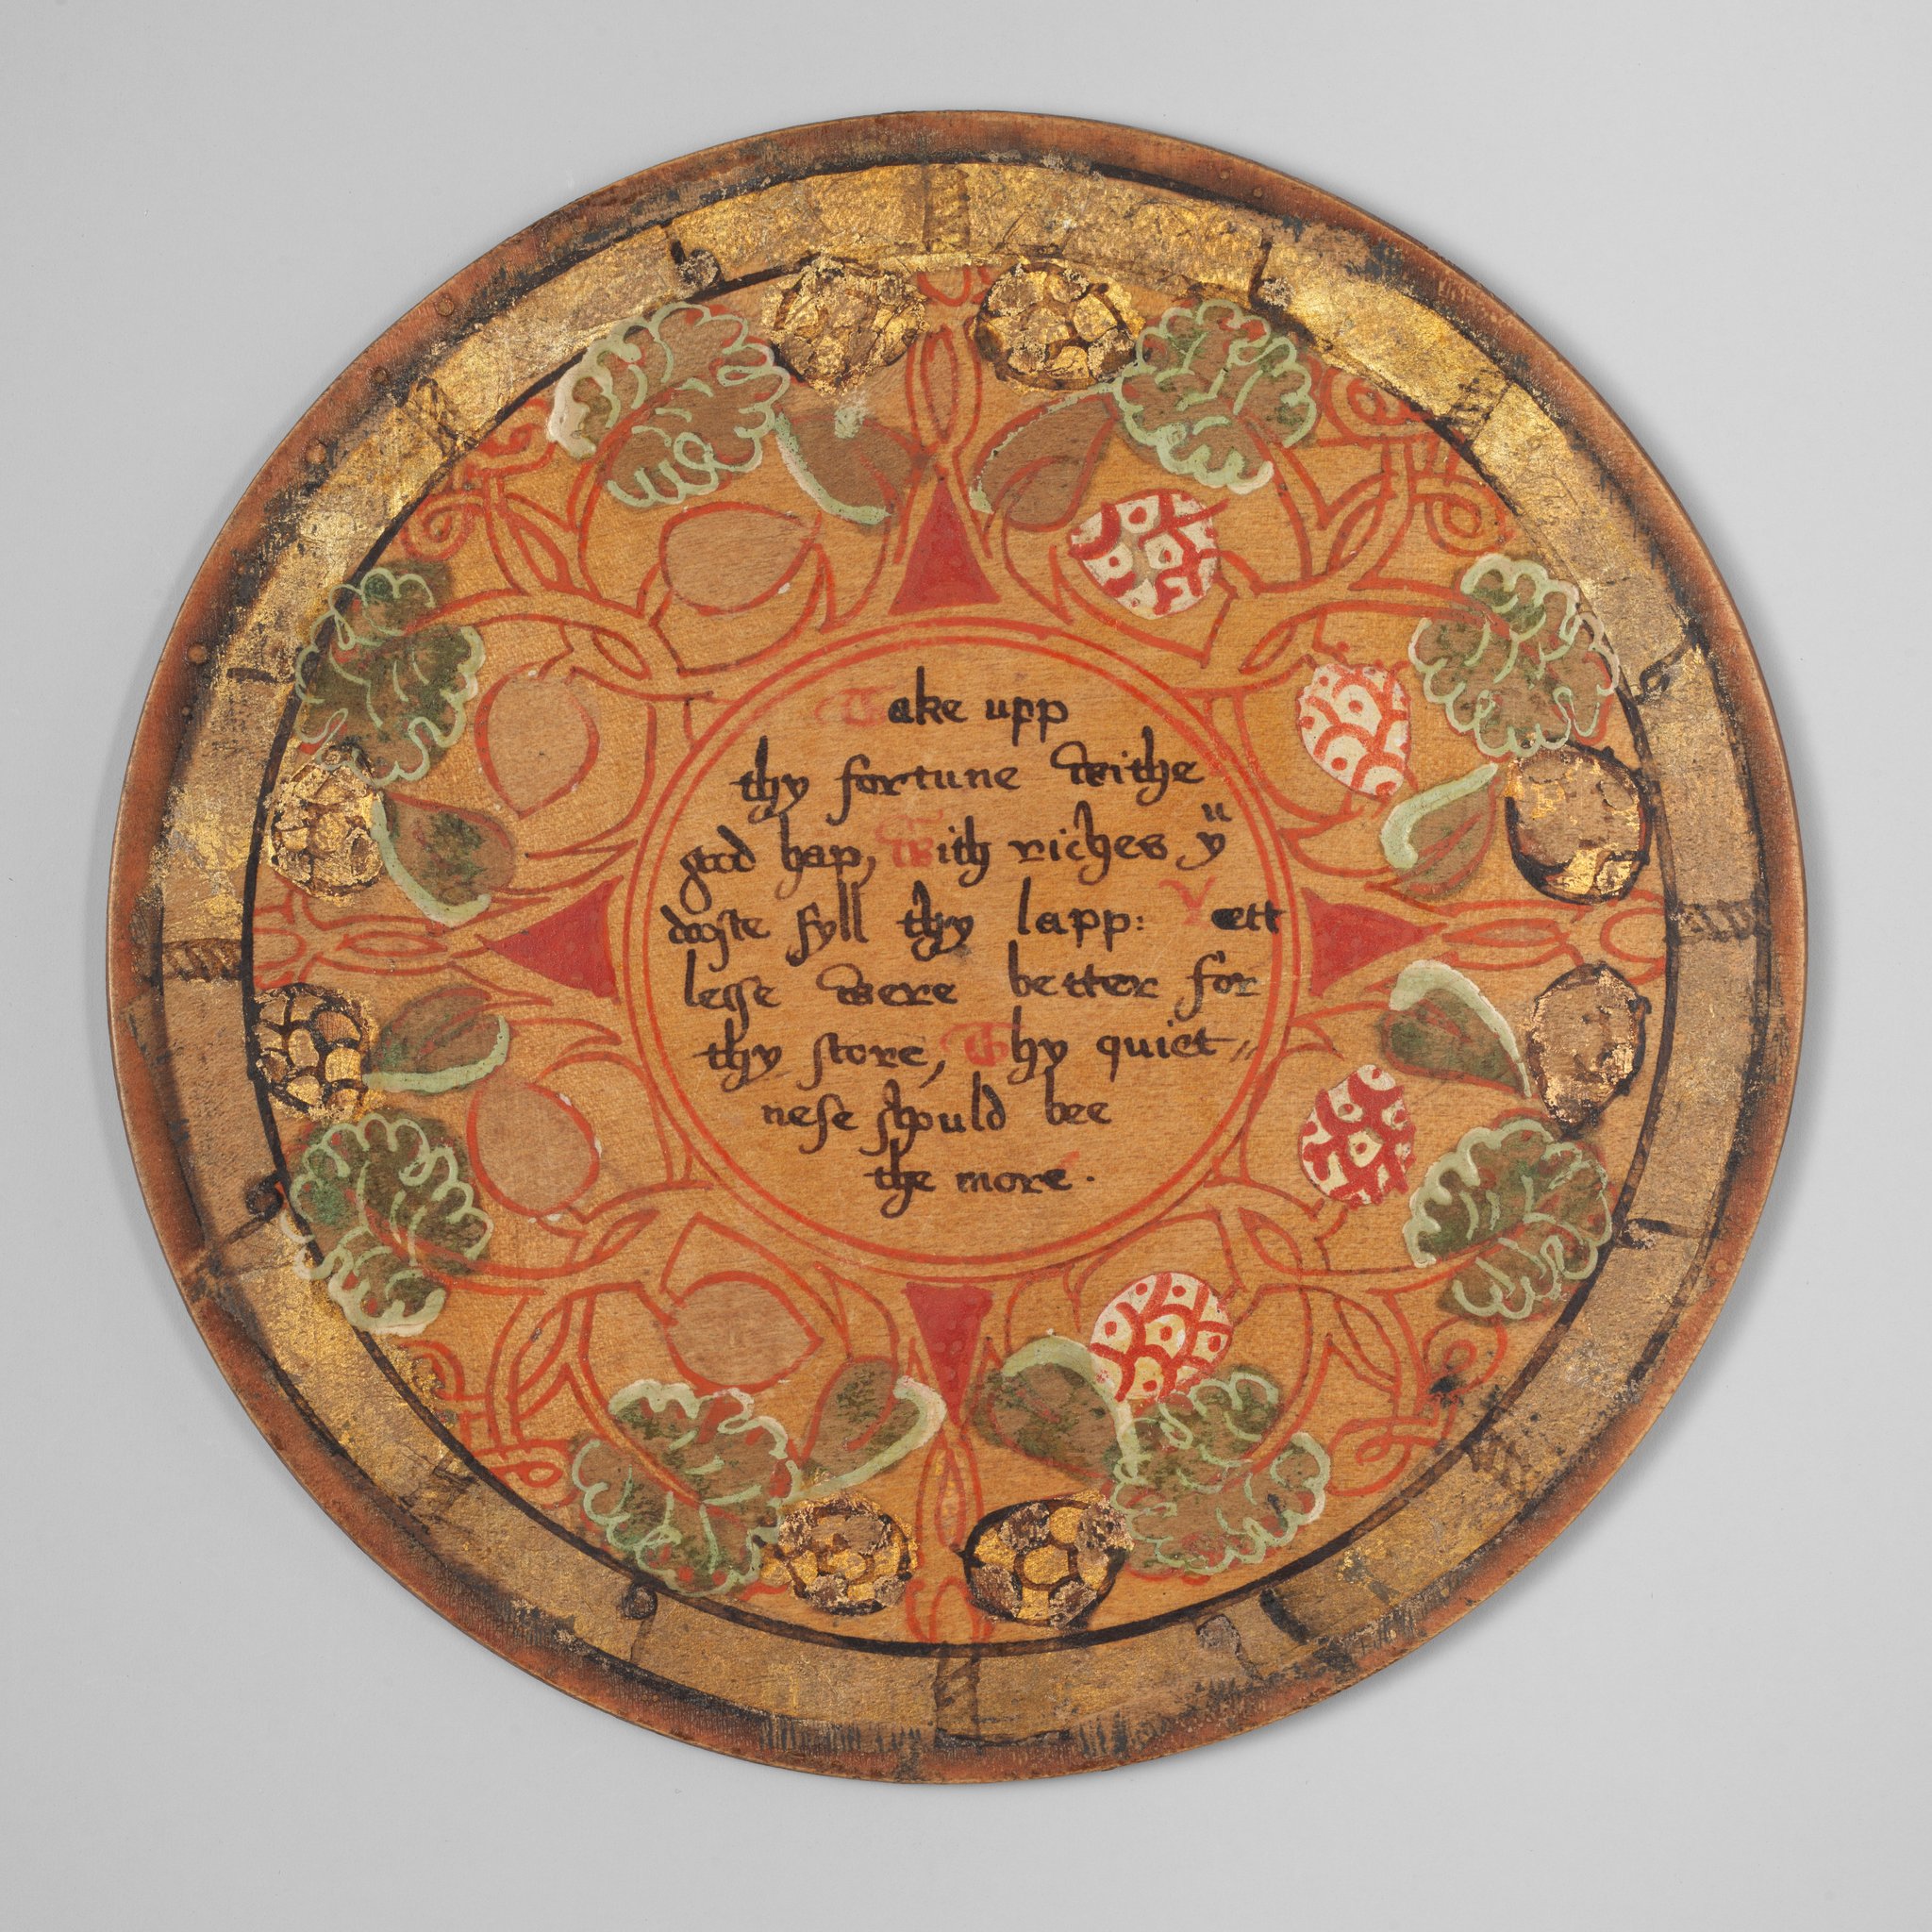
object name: trencher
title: Trencher (one of a set)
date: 1567-1633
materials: ink, wood, varnish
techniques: painting, silvered